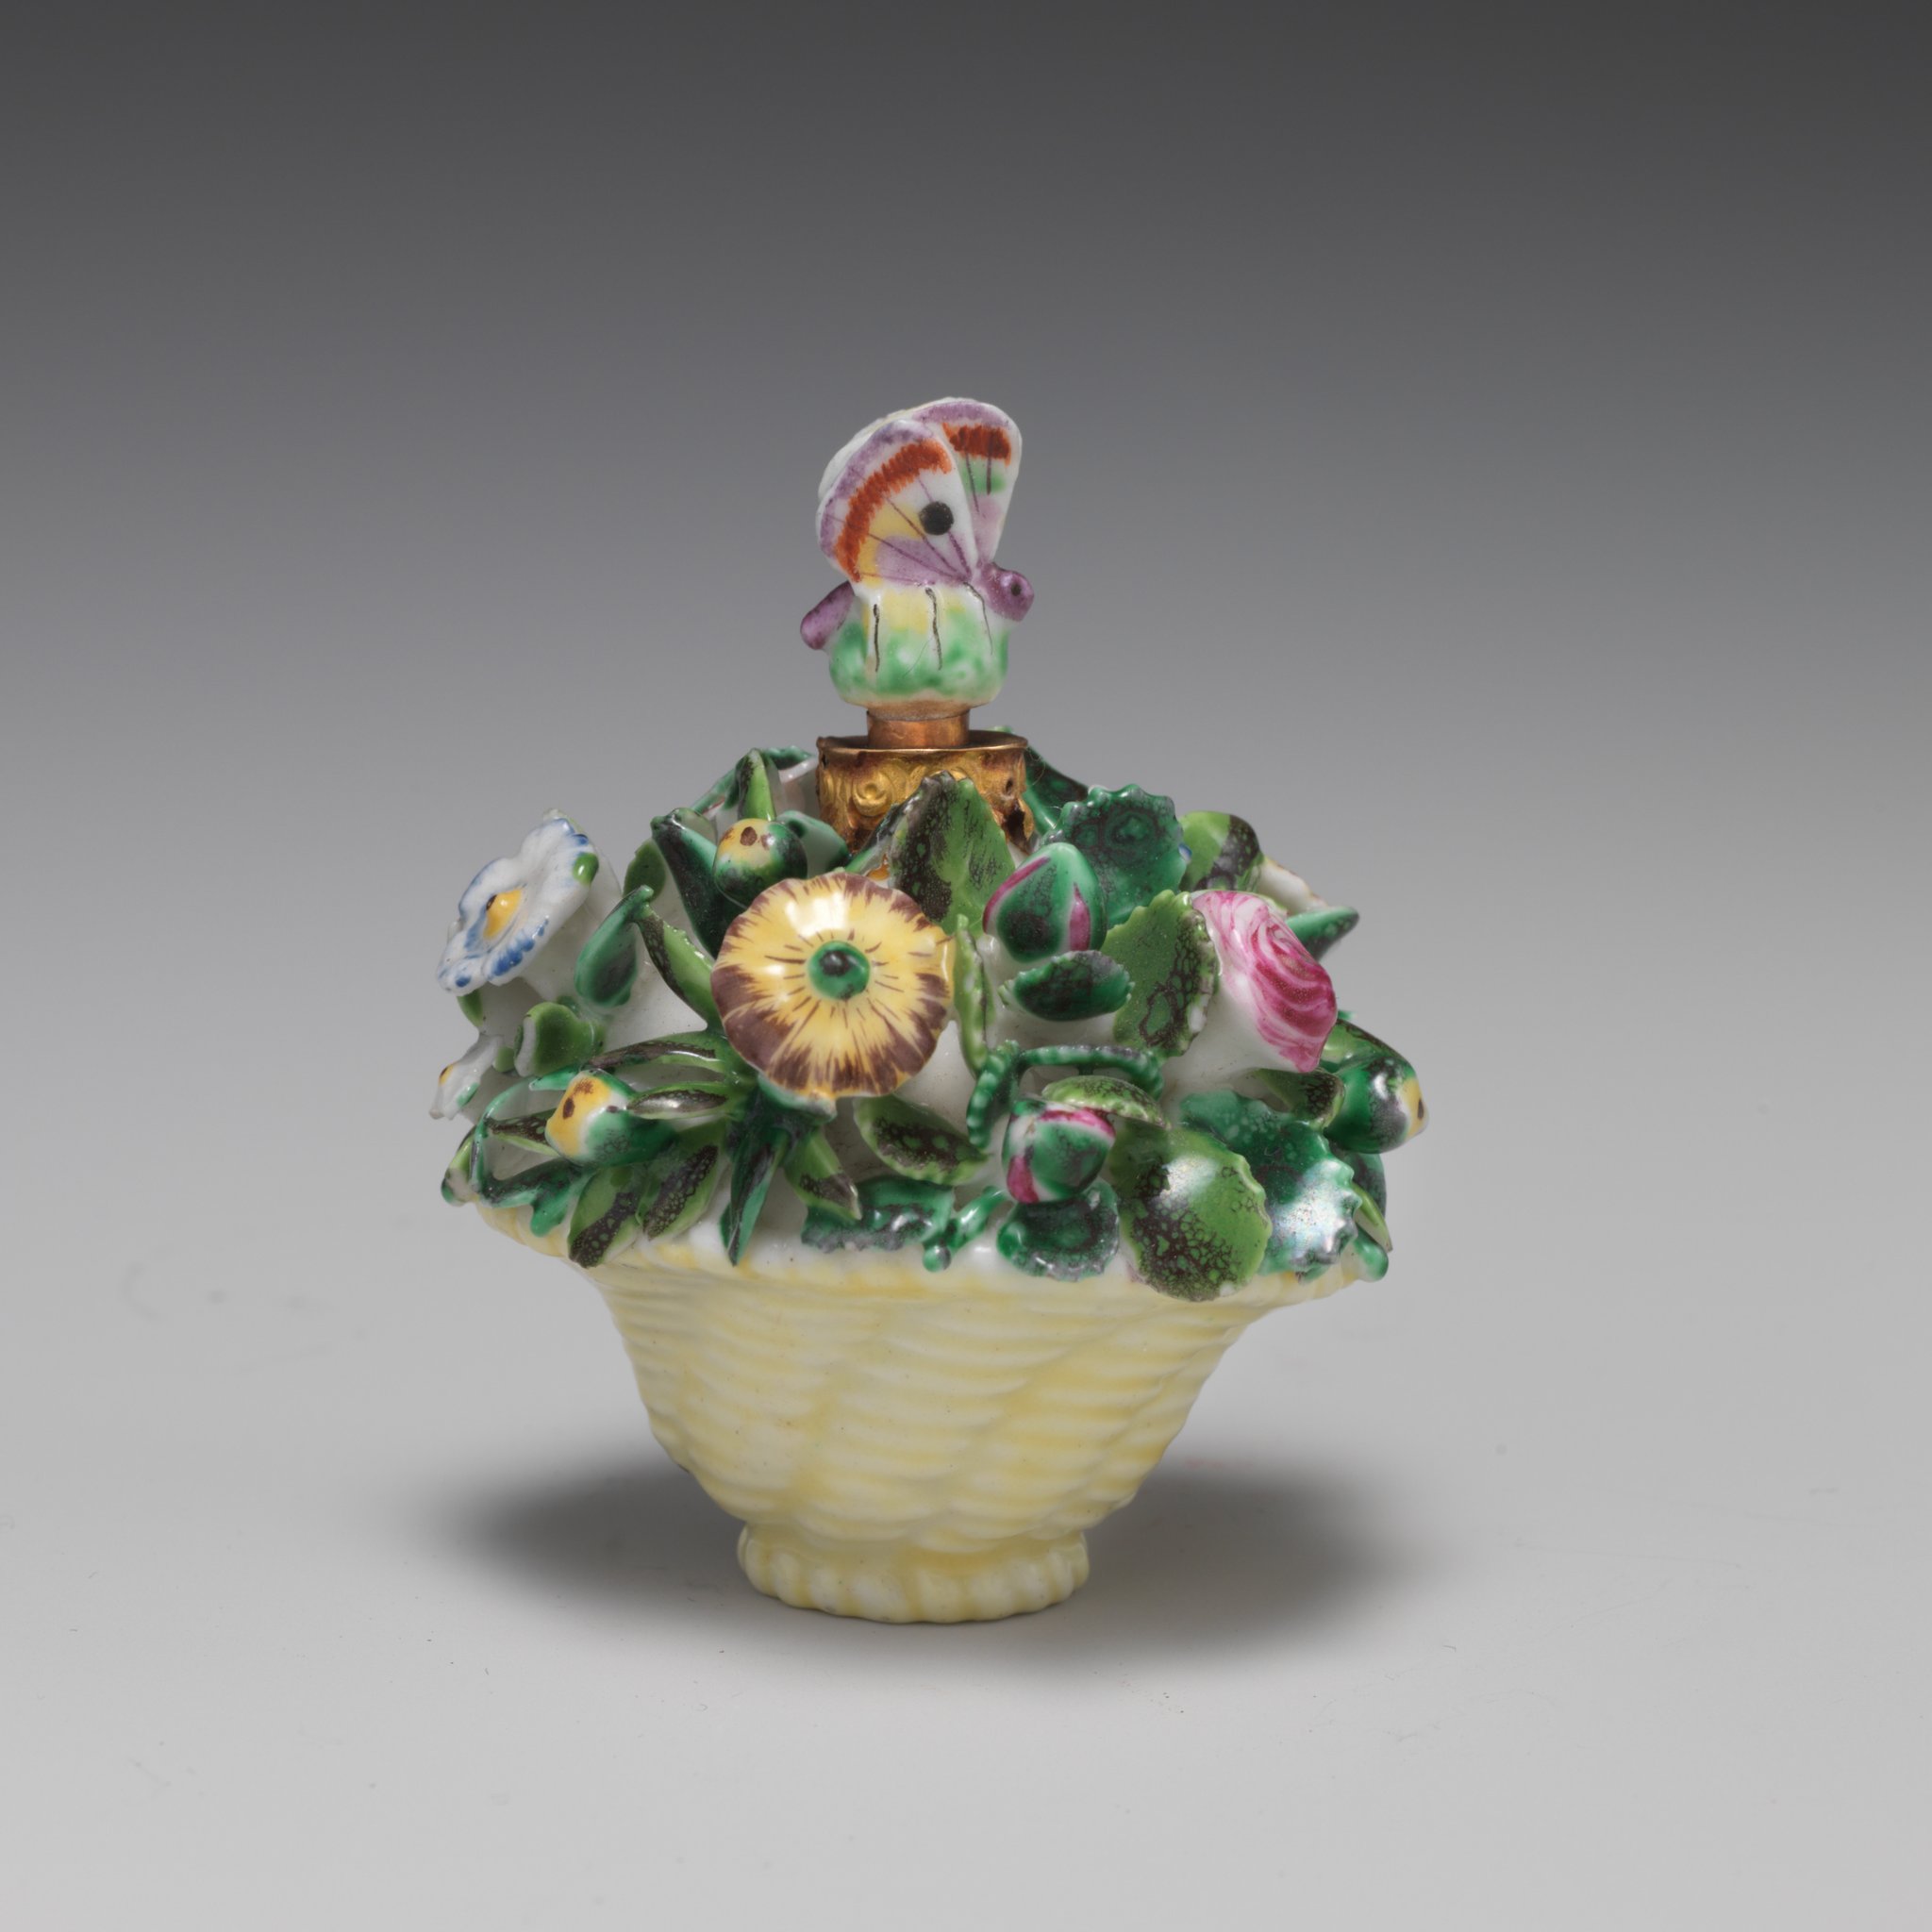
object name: toy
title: Basket of flowers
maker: saint james's factory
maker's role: maker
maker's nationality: british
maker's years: 1749-1759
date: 1755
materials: soft paste porcelain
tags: butterflies,flowers